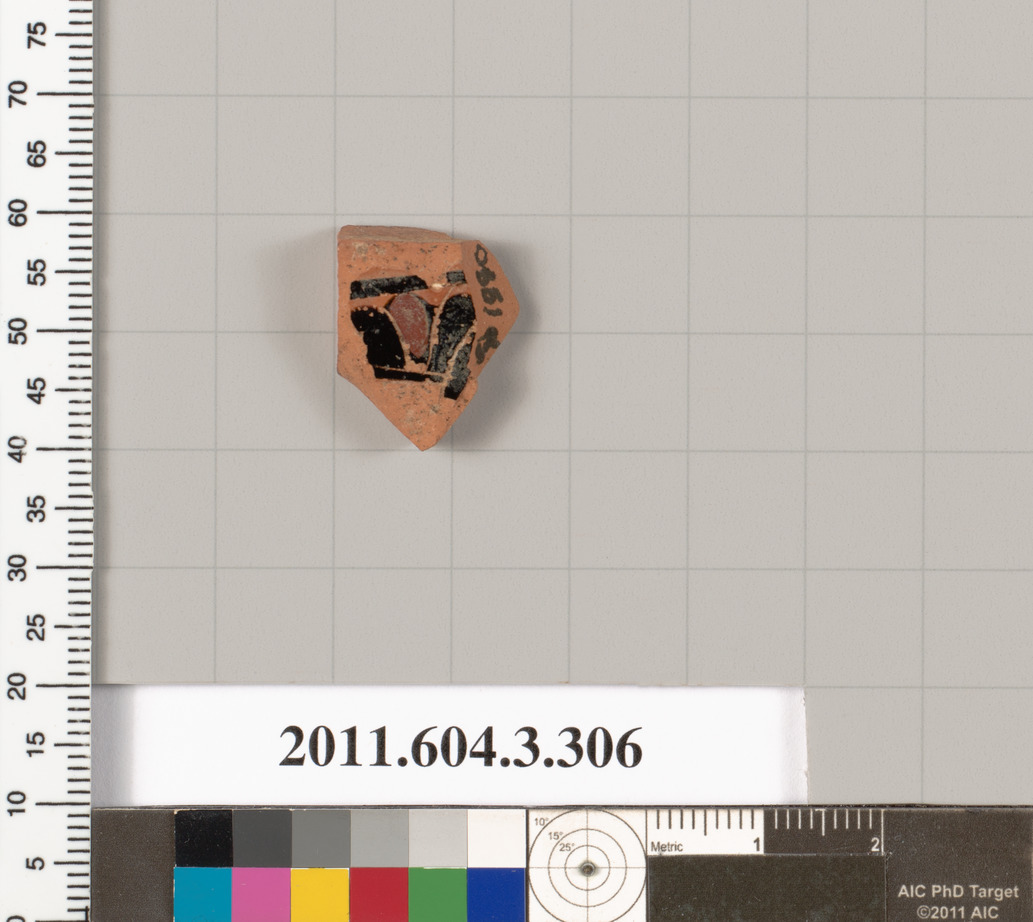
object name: neck amphora fragment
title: Terracotta fragment of a neck-amphora (jar)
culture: greek, attic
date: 550-526 BCE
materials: terracotta